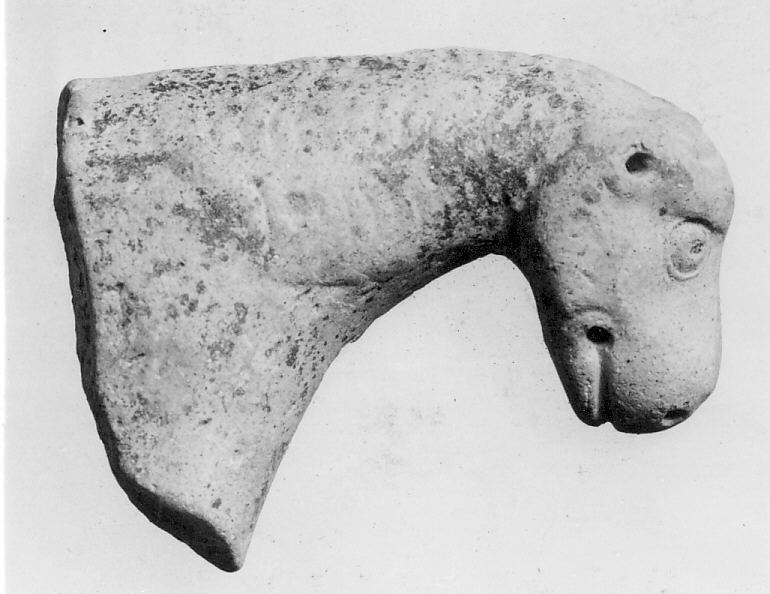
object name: handle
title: Head of a Horse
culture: central asian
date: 1101-1133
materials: earthenware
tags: horses